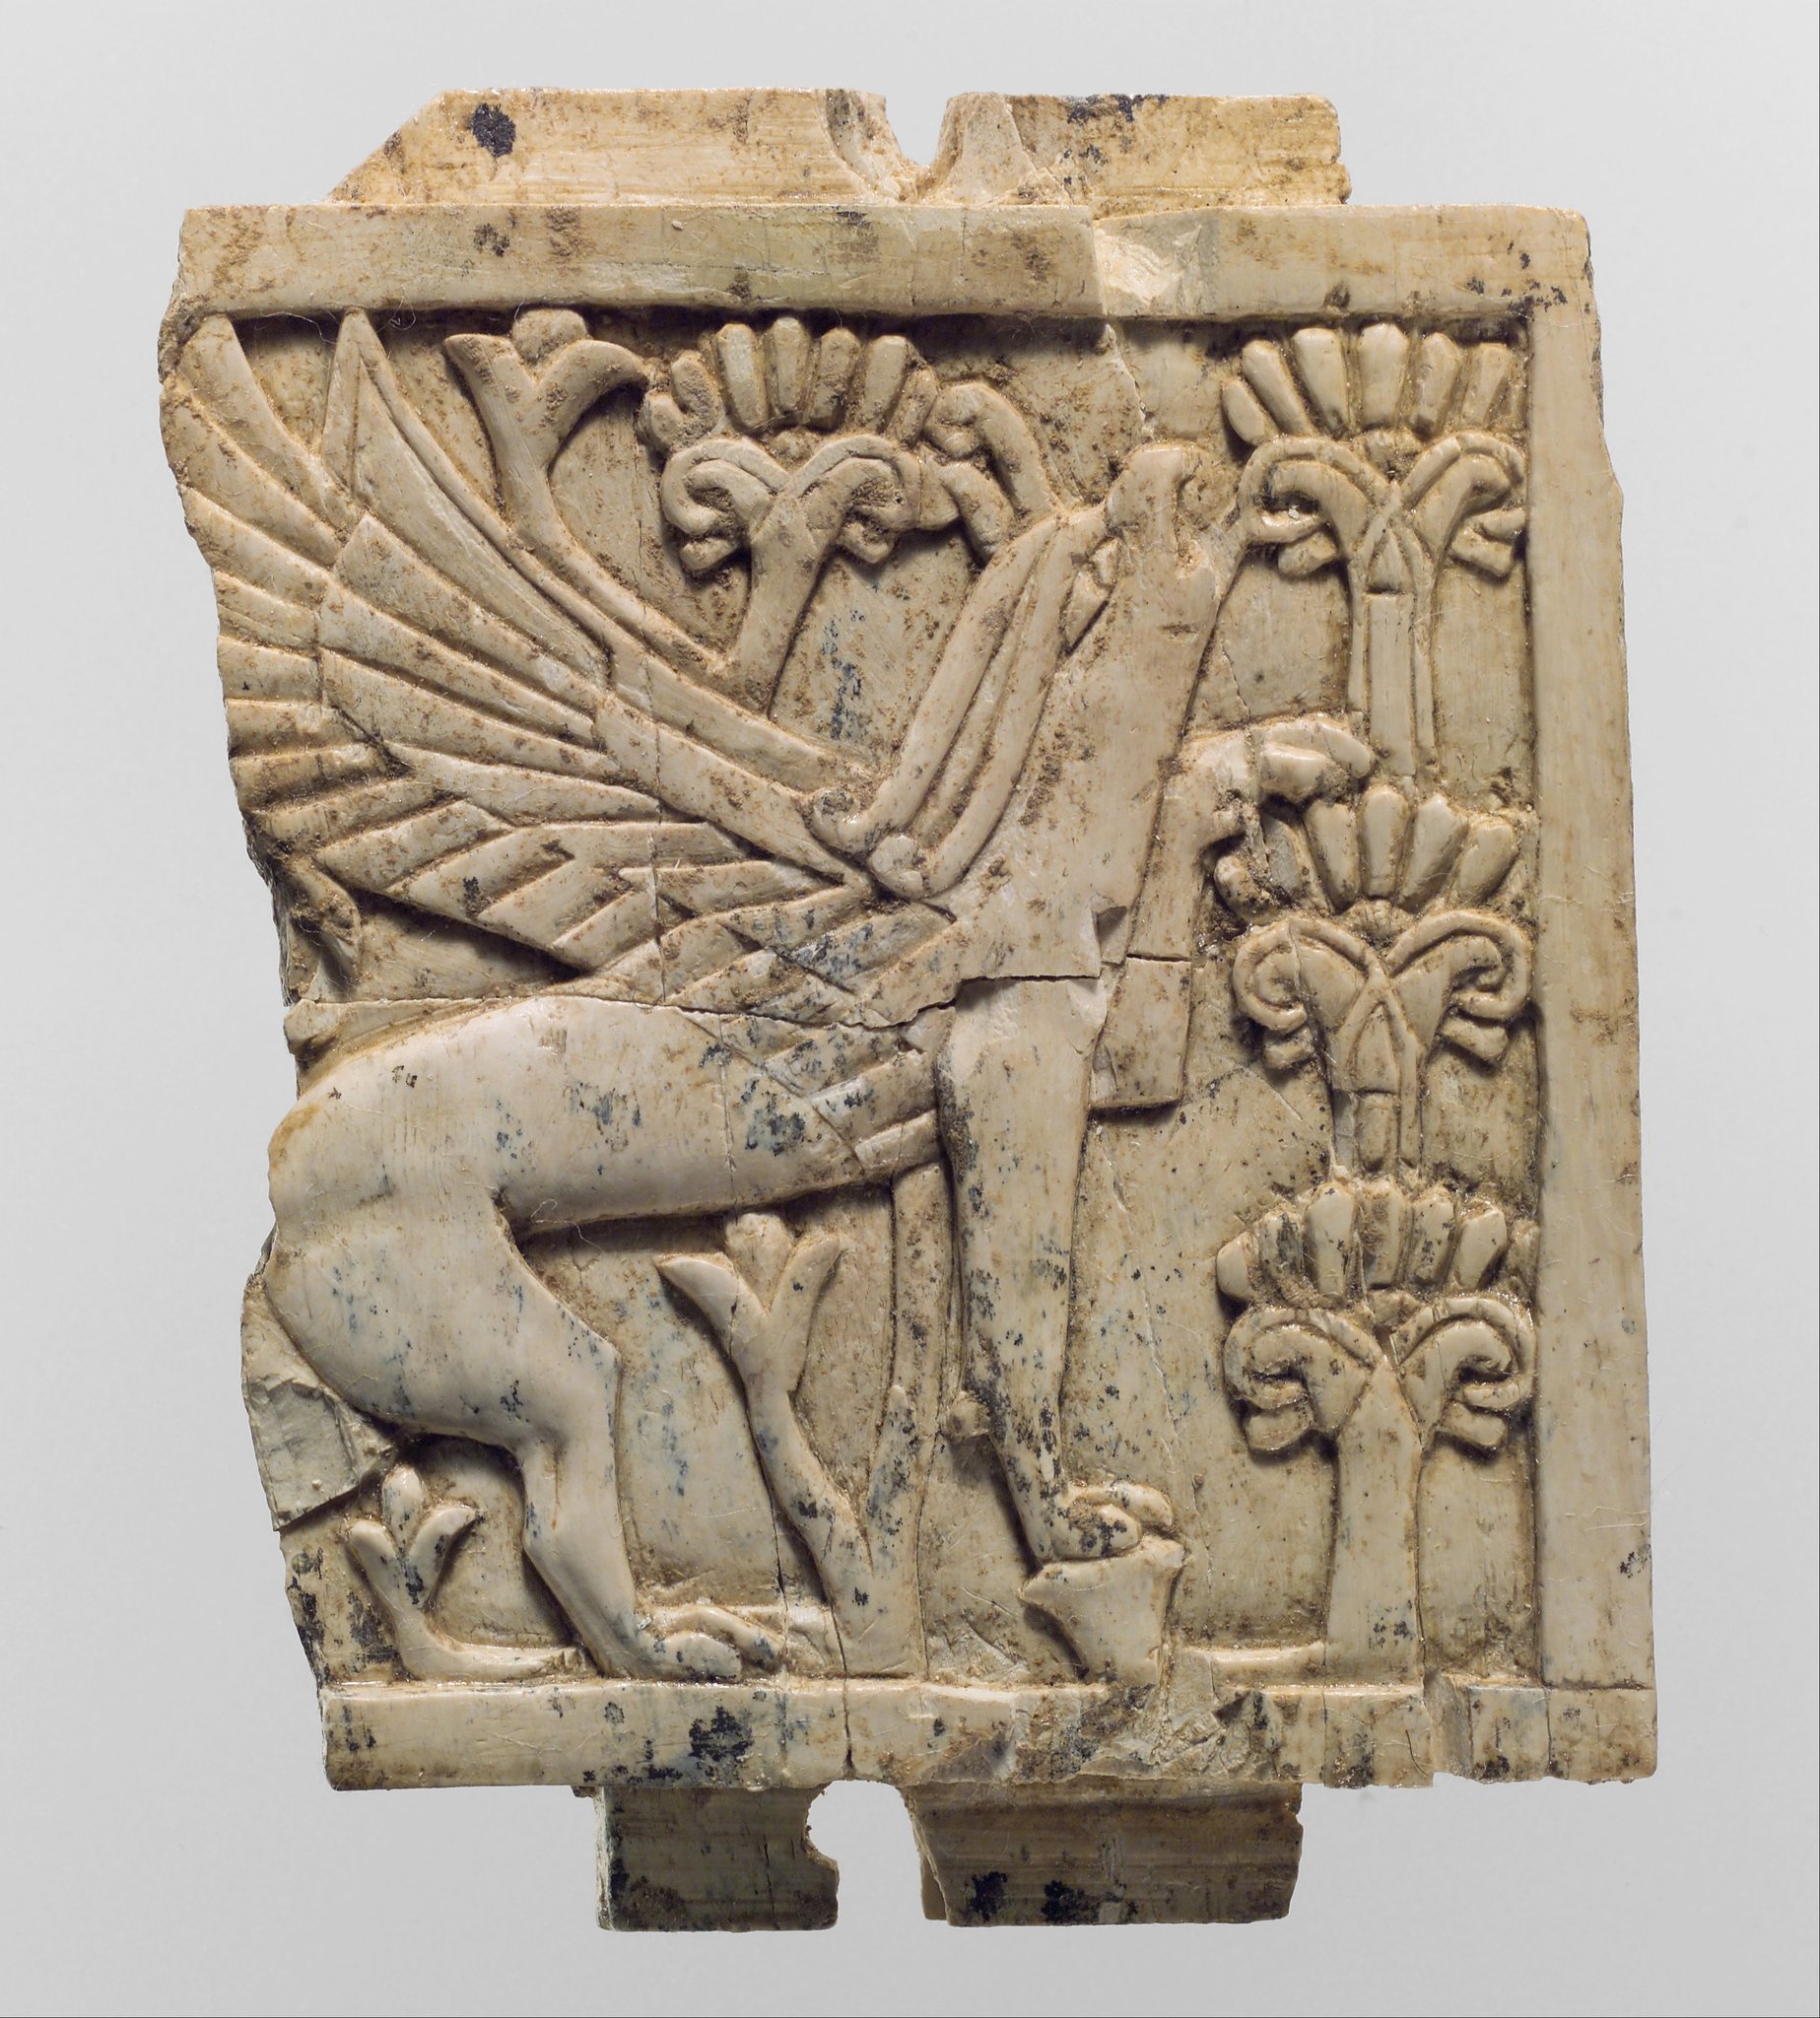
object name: relief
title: Furniture plaque carved in relief with a griffin in a floral landscape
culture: assyrian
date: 900-701 BCE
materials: ivory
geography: mesopotamia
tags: griffins,flowers